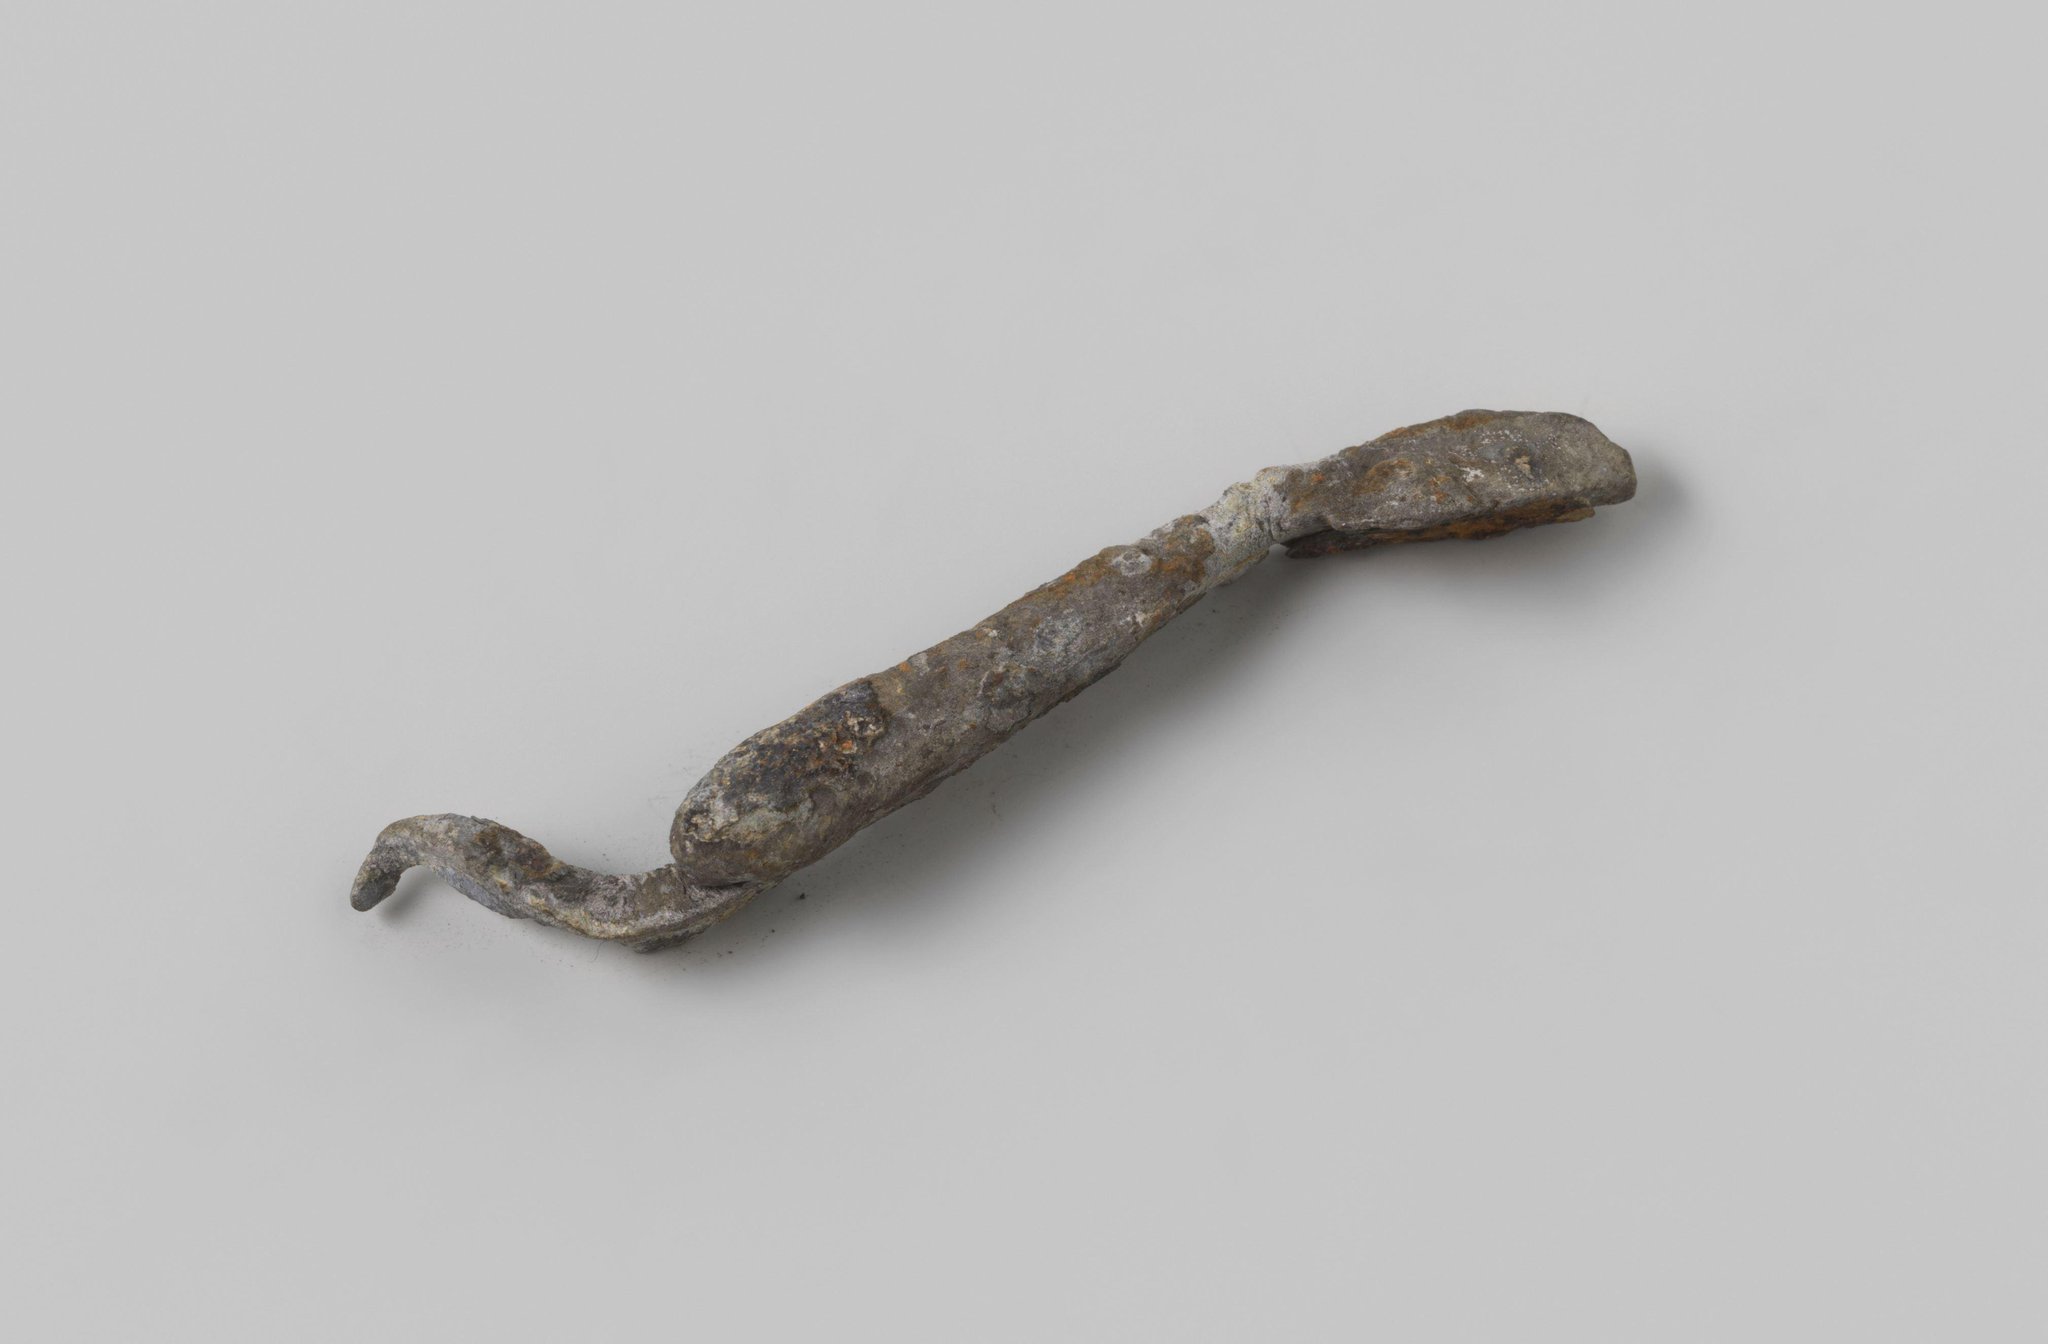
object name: cartridge shell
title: Beslag van patroonhuls uit het wrak van de Oost-Indiëvaarder Hollandia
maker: Anonymous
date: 1700-1743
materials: lead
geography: netherlands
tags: verenigde oostindische compagnie, hollandia (schip), annet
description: Cartridge case, tube solder; id. NG 1979-205H549.